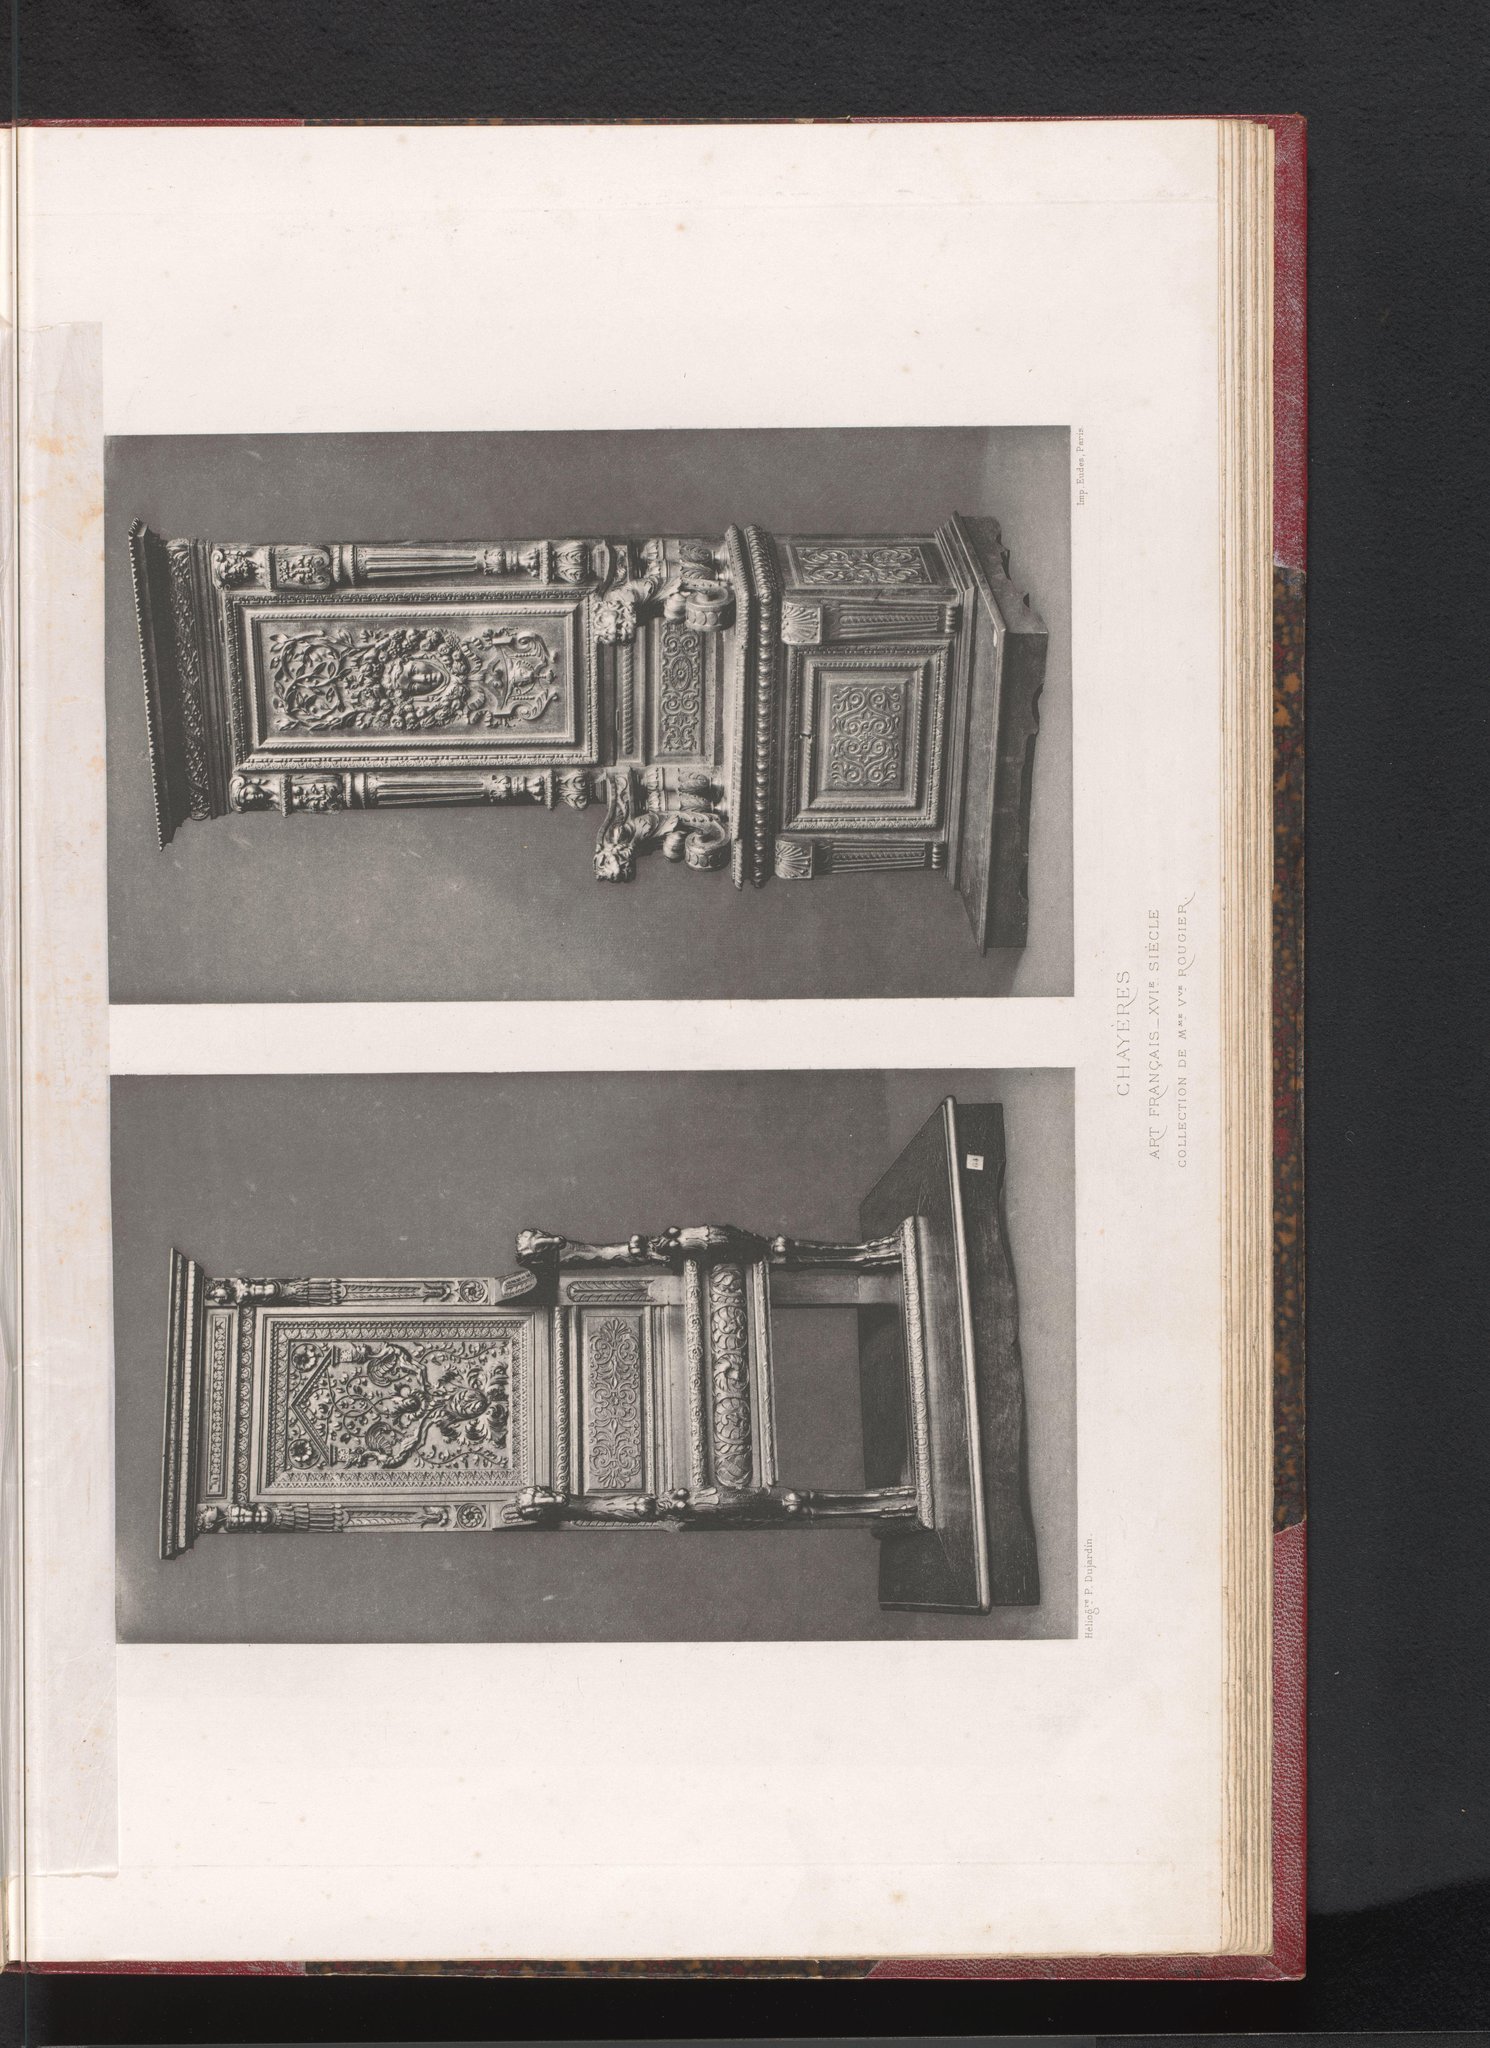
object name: photomechanical print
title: Twee 16de-eeuwse Franse zetels van hout, op de Exposition Rétrospective van 1877 in Lyon, Frankrijk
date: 1877-1880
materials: paper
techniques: photoaquatint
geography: lyon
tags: chair (+ wood and other phytogenic material), lyon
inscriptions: inscription: ‘EXPOSITION RÉTROSPECTIVE DE LYON/ PAR J. B. GIRAUD.’, number: ‘PL. XIX.’, number: ‘PL. XVIII.’, inscription: ‘CHAYÈRES/ ART FRANÇAIS_XVIe SIÈCLE/ COLLECTION DE Mme Vve ROUGIER.’